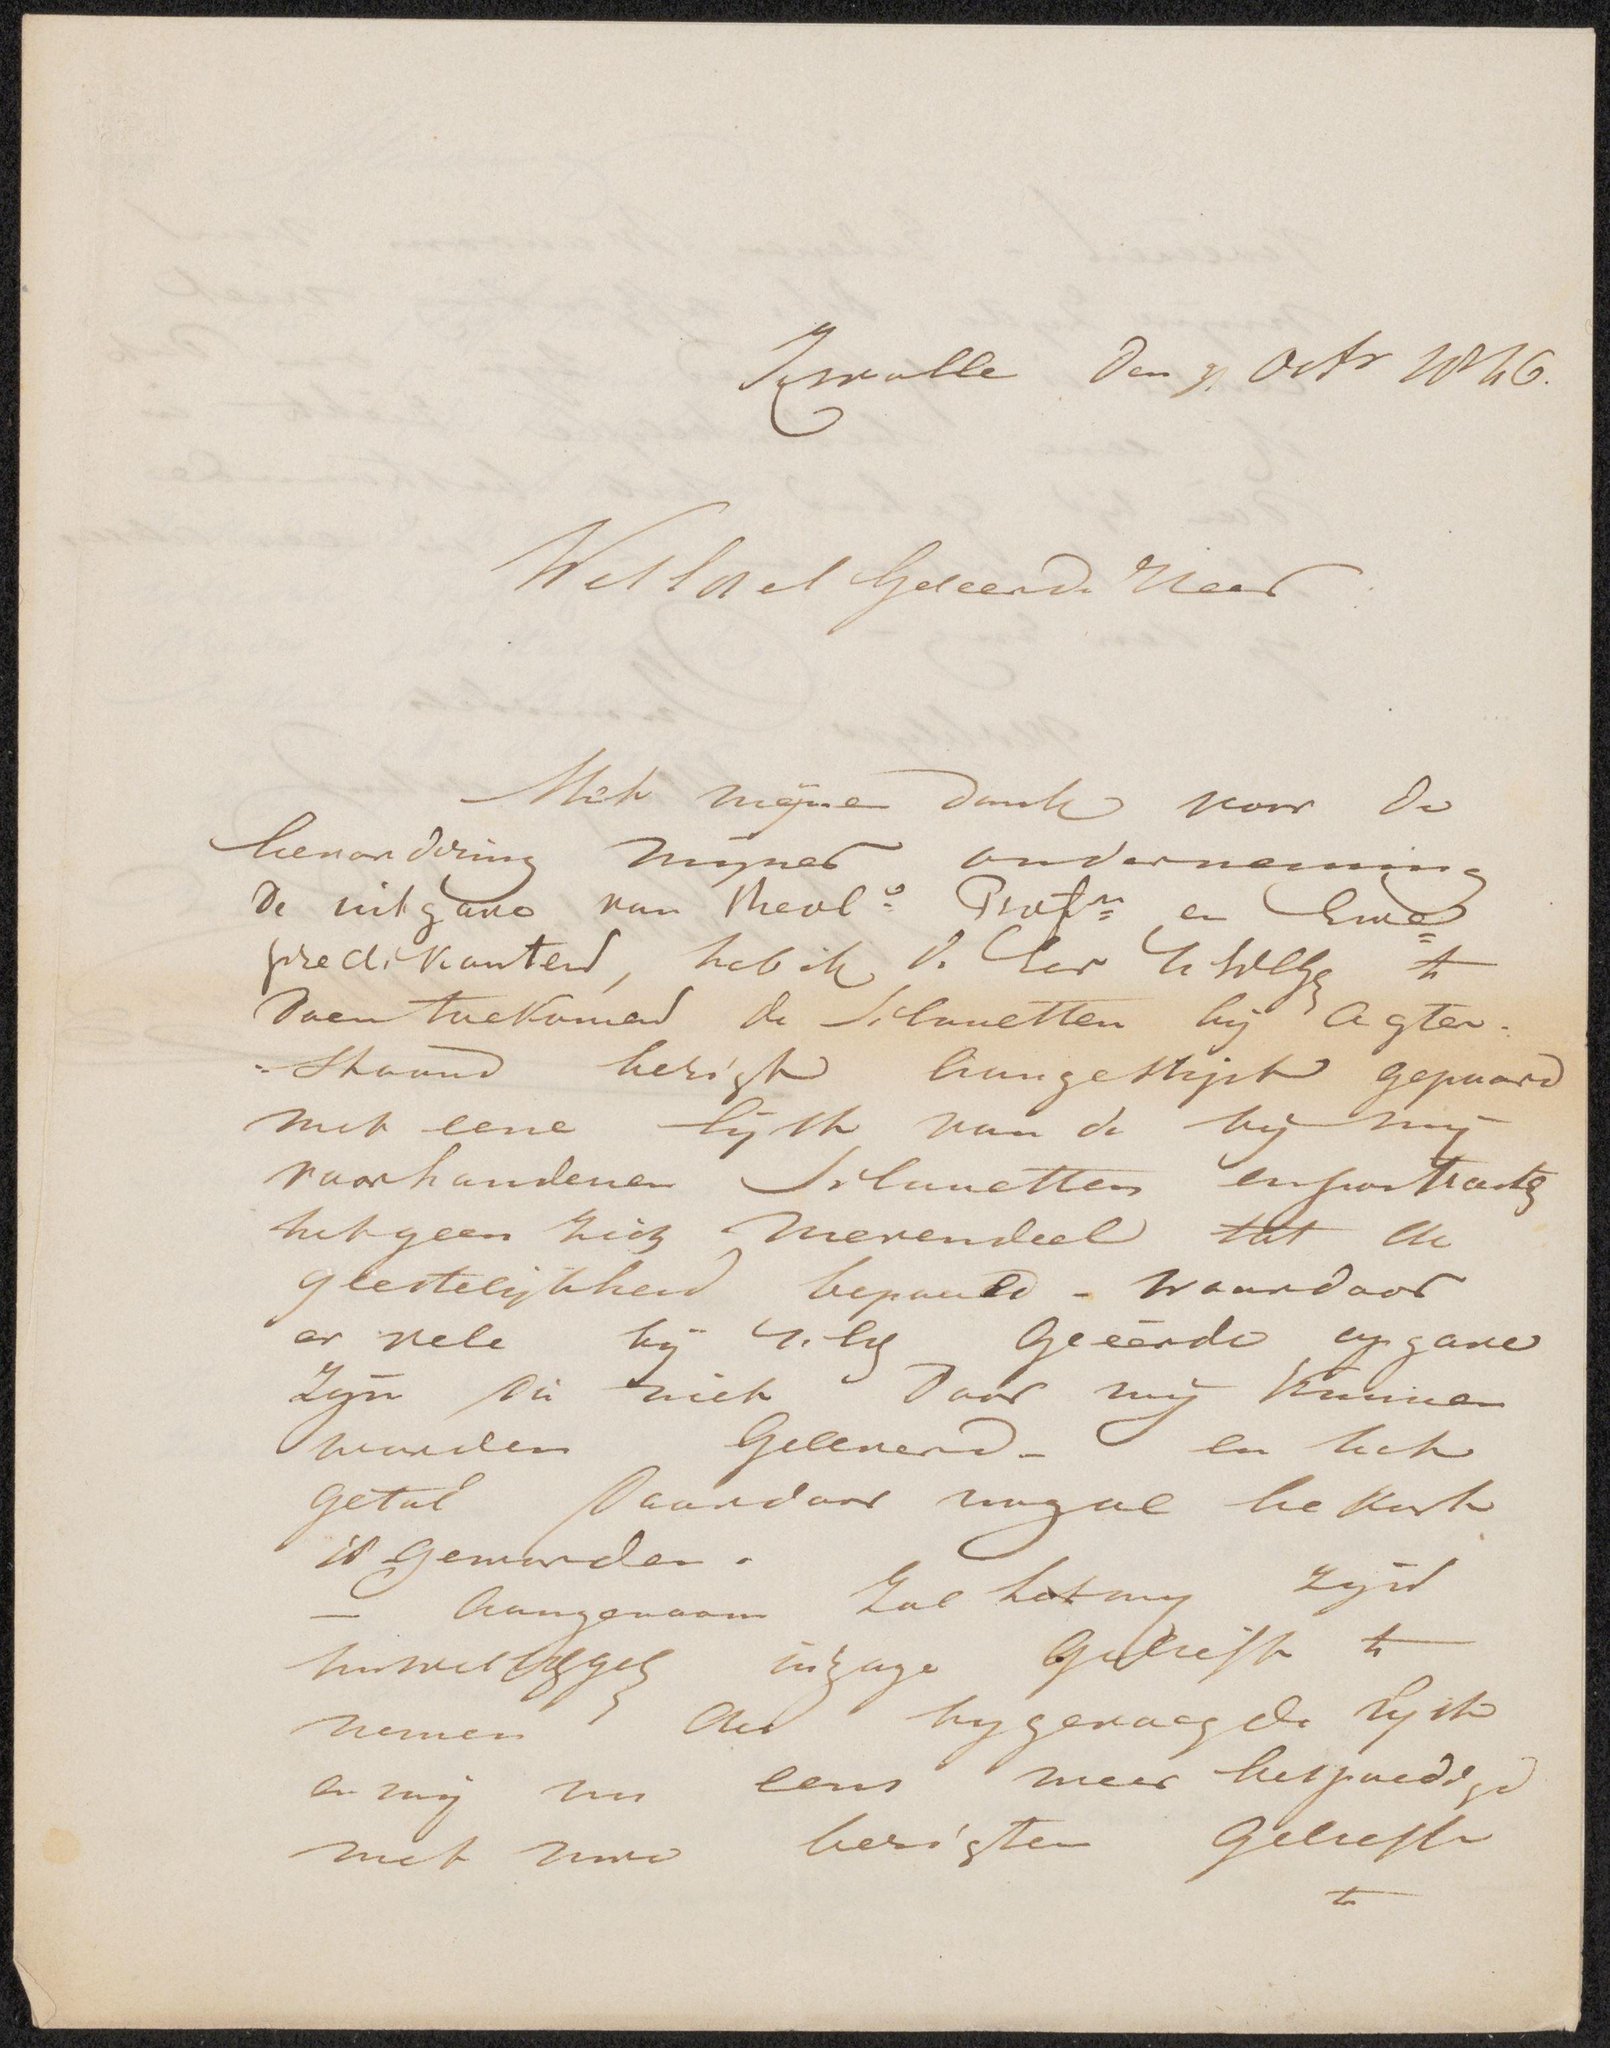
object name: letter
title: Brief aan anoniem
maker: pieter barbiers (iv)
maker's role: painter, print maker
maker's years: 1798-1848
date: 1846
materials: ink, paper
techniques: pen, writing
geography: zwolle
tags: the graphic arts, diseases, historical persons (portraits and scenes from the life), money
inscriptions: collector's mark: ‘RPK’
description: Brief bevat een lijst van silhouetportretten.